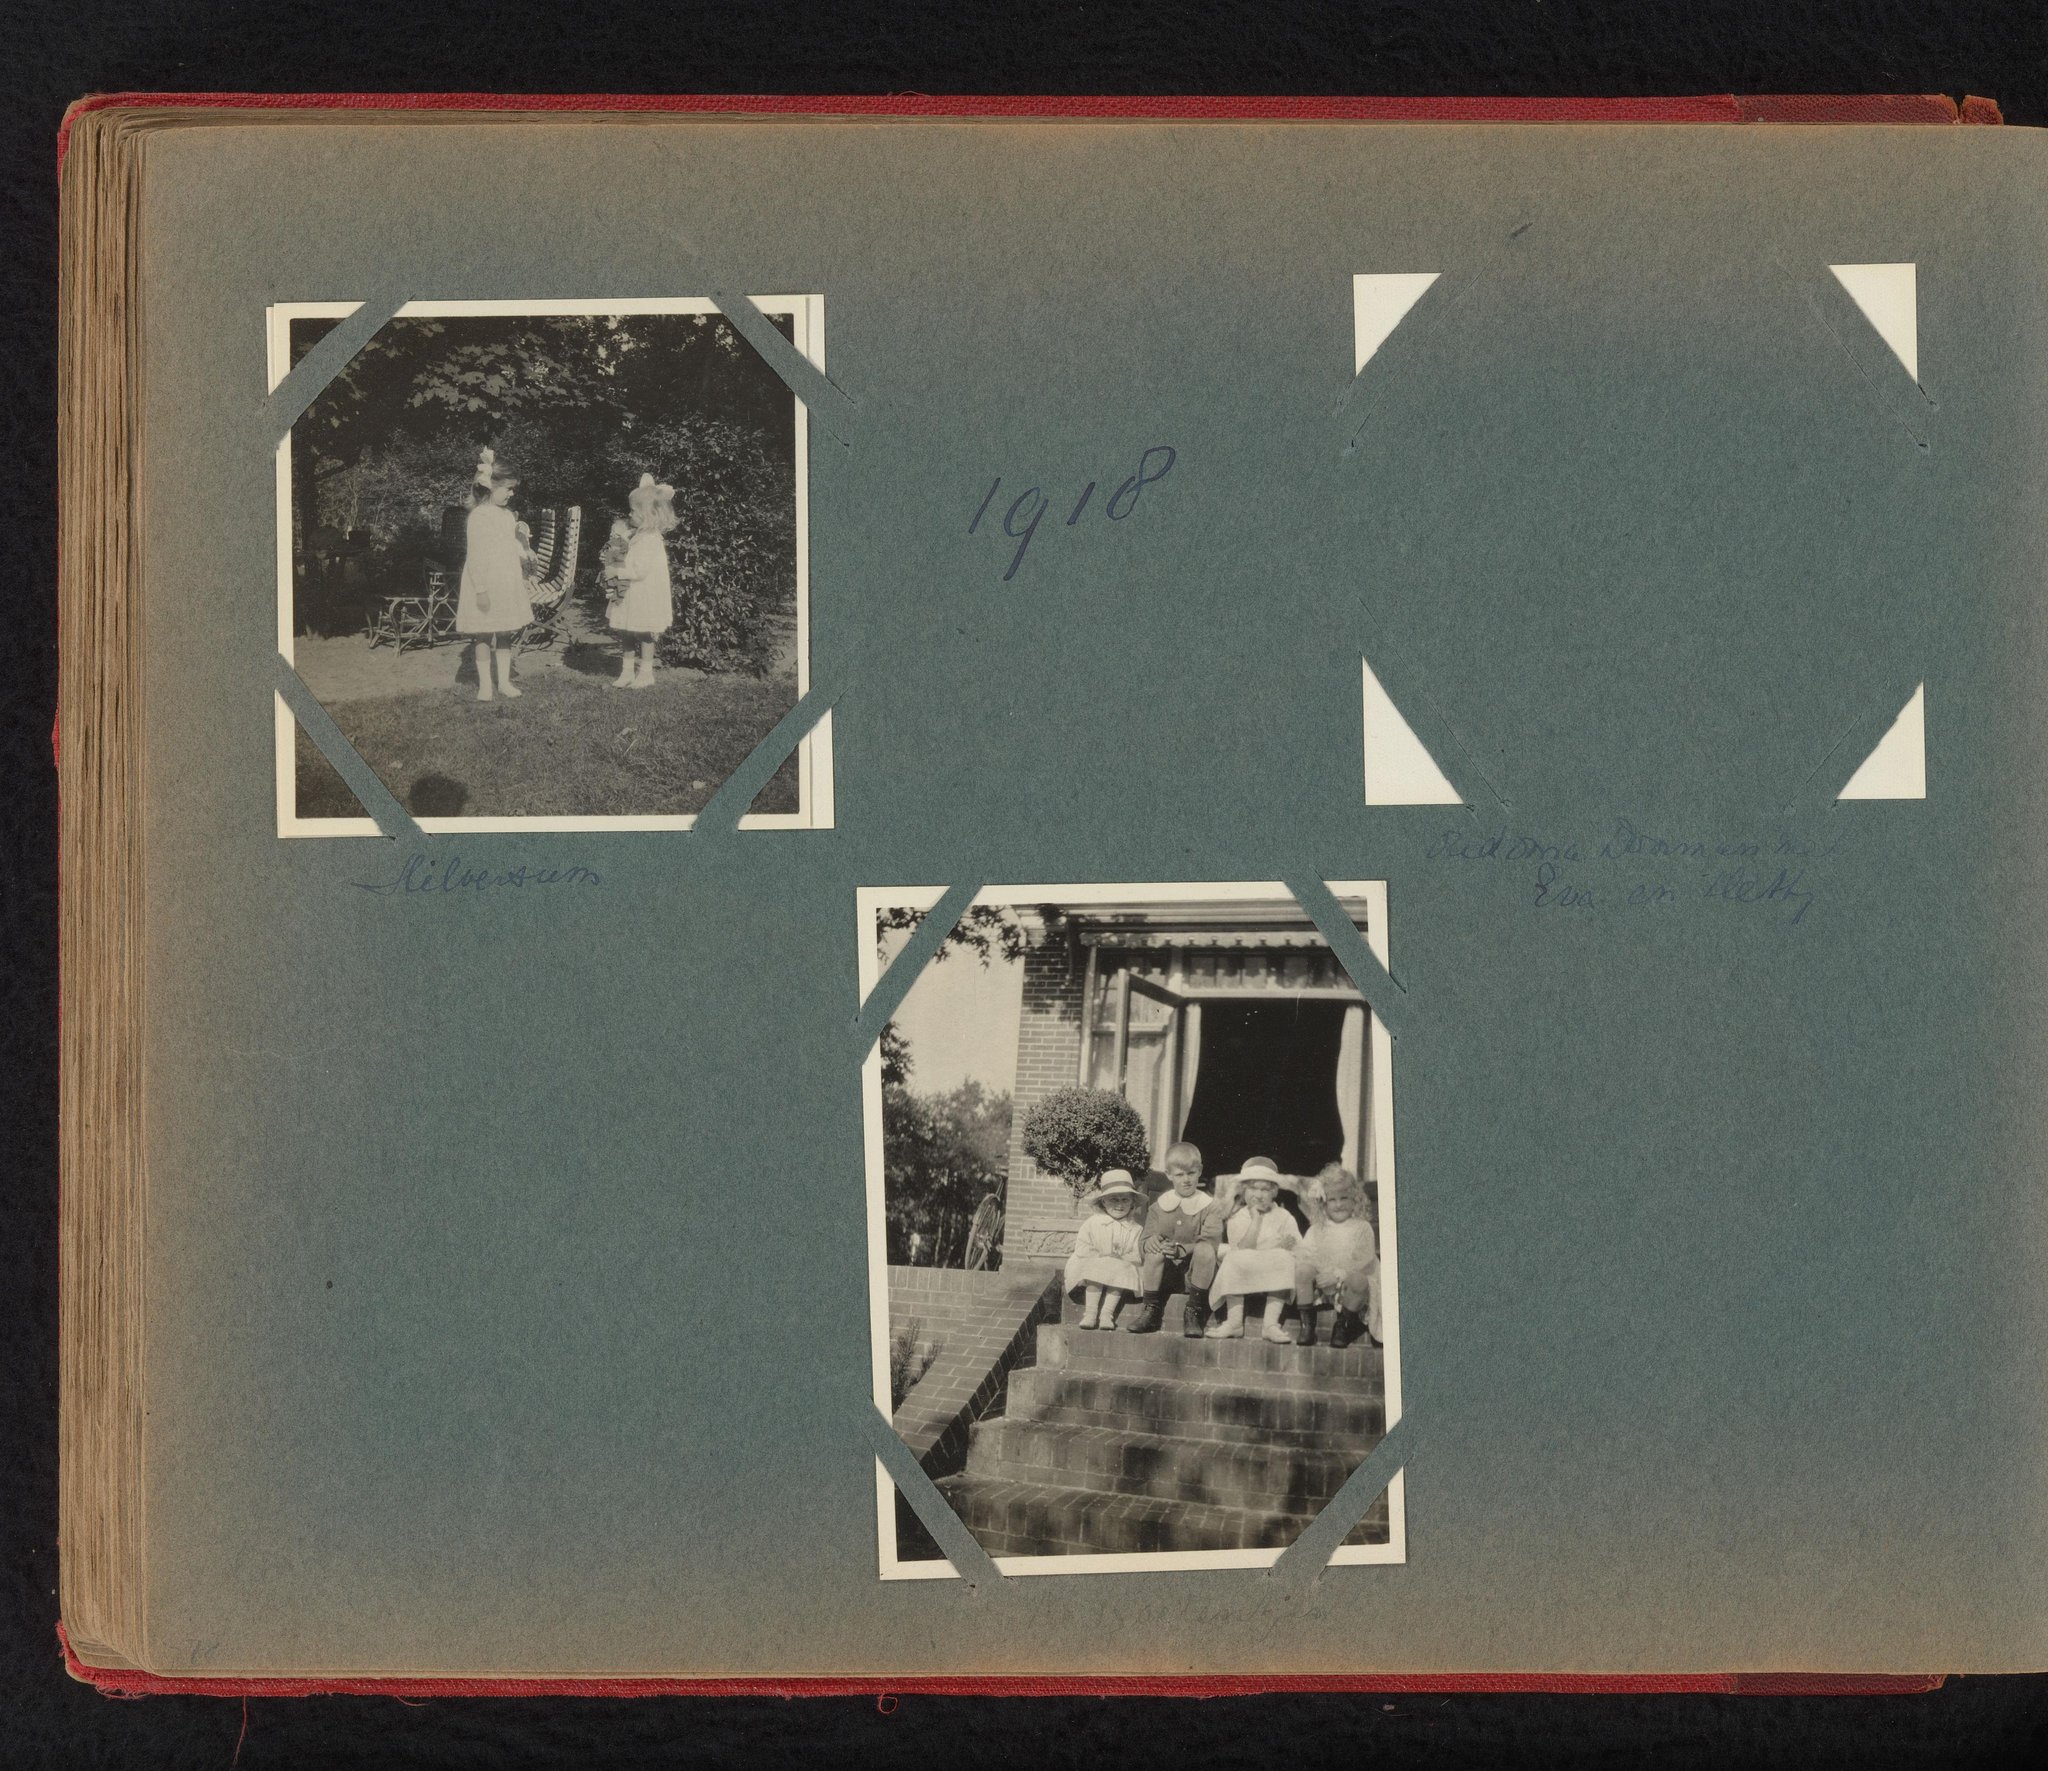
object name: photograph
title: Eva en Hetty Boelen met hun neven en nichten in Hilversum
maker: charlotte alida boelen-matthes (lot)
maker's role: amateurfotograaf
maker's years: 1889-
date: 1918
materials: paper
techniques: gelatin silver print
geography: hilversum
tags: amsterdam, eva charlotte pennink-boelen, garden, cousins (third degree family relationships)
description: Deze foto's zijn onderdeel van een album.